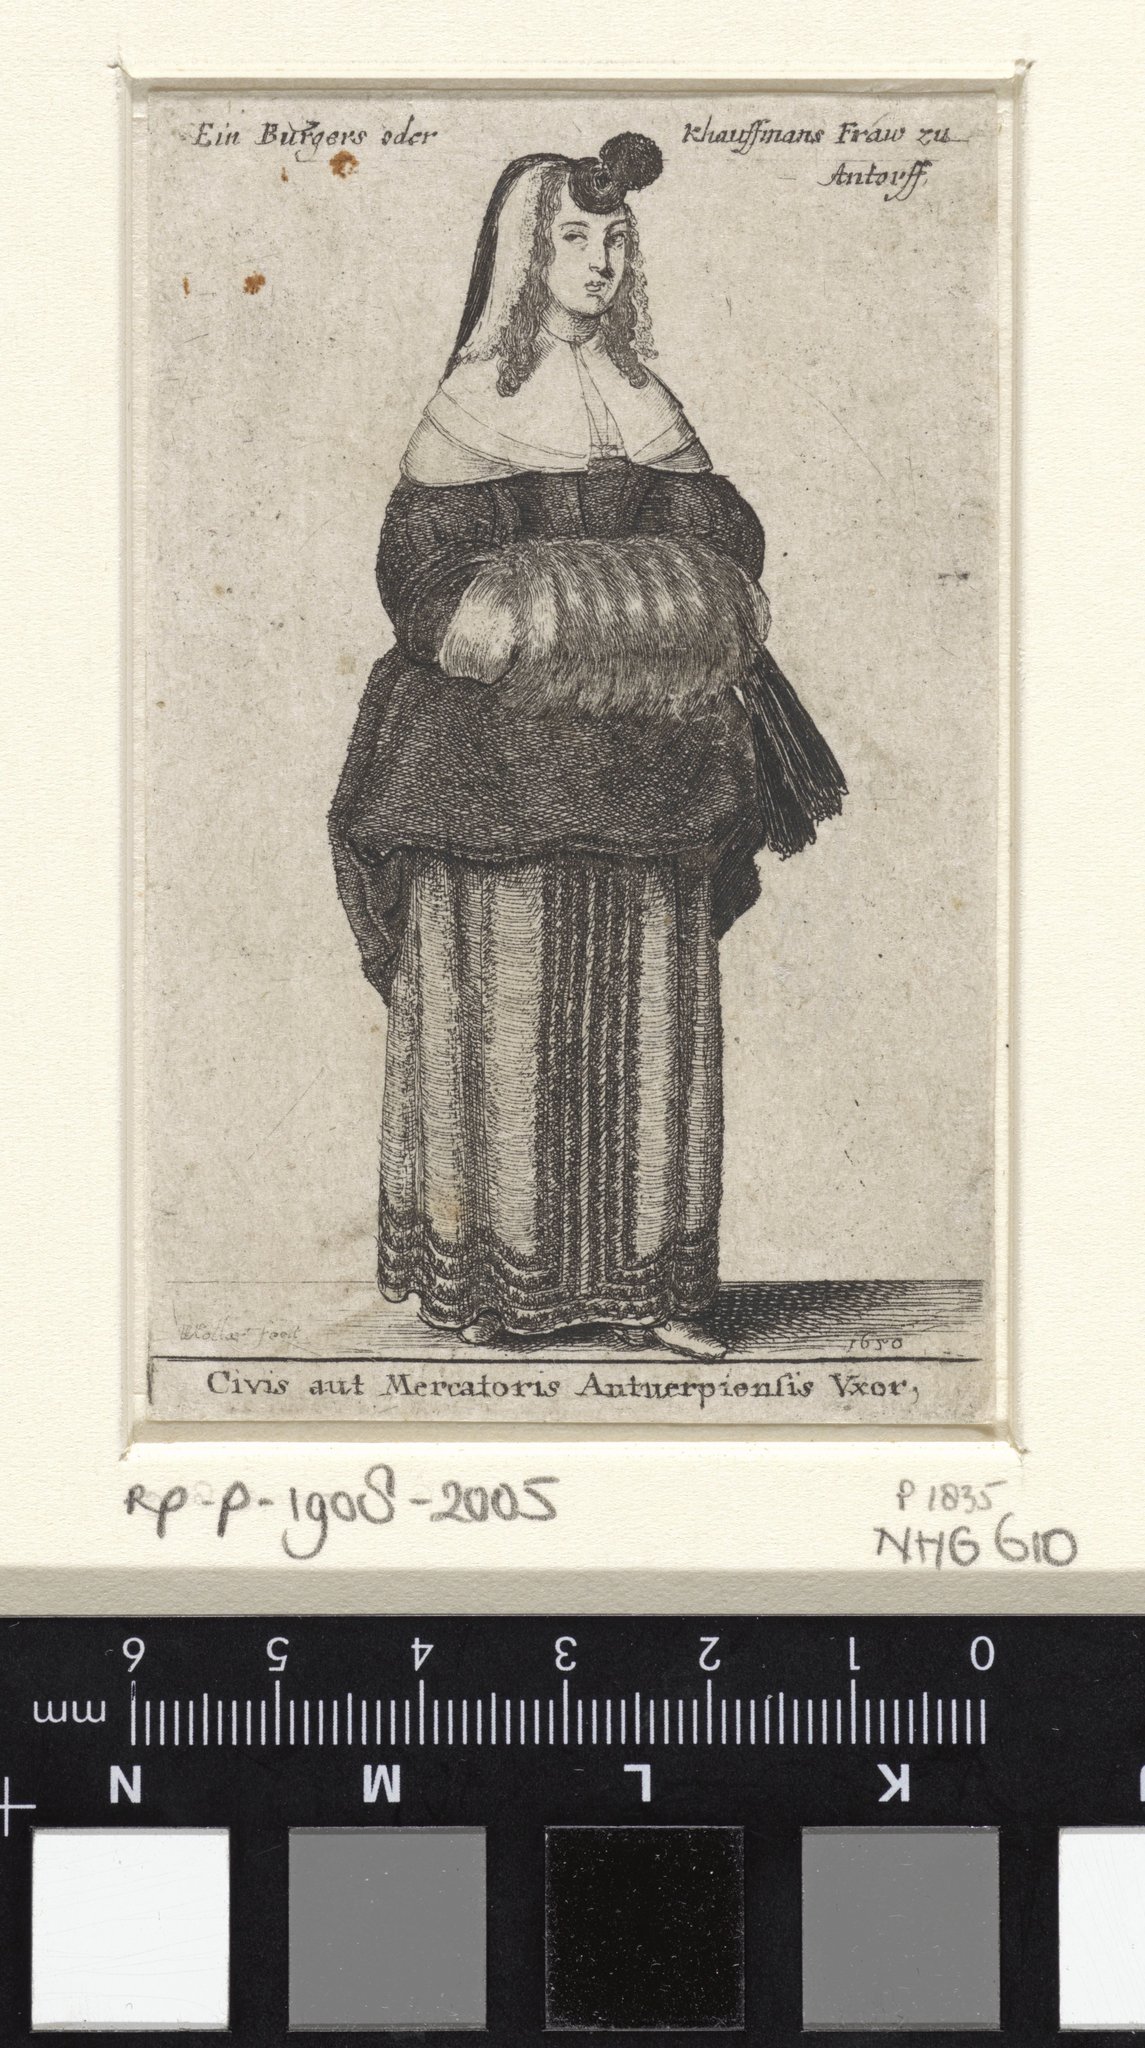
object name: costume print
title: Koopmansvrouw uit Antwerpen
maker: wenceslaus hollar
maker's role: draughtsman, print maker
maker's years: 1607-1677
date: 1650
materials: paper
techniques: etching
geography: london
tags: neck-gear ~ clothing (neckerchief) (+ women's clothes), cape (huik) (+ women's clothes), skirt (underskirt) (+ women's clothes), clothes, costume (+ women's clothes), shoes, sandals (+ women's clothes), skirt (+ women's clothes), clothing for the upper part of the body (with name) (+ women's clothes), muff (+ women's clothes), antwerp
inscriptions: collector's mark: Lugt 240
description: Koopmansvrouw uit Antwerpen, iets naar rechts, gekleed in een huik die vastzit aan een plat hoedje met steel als handvat op het voorhoofd. Witte hooggesloten kraag boven een donker overkleed dat van achteren is opgenomen, zodat het onderkleed met passement is te zien. De handen in een grote mof van bont.